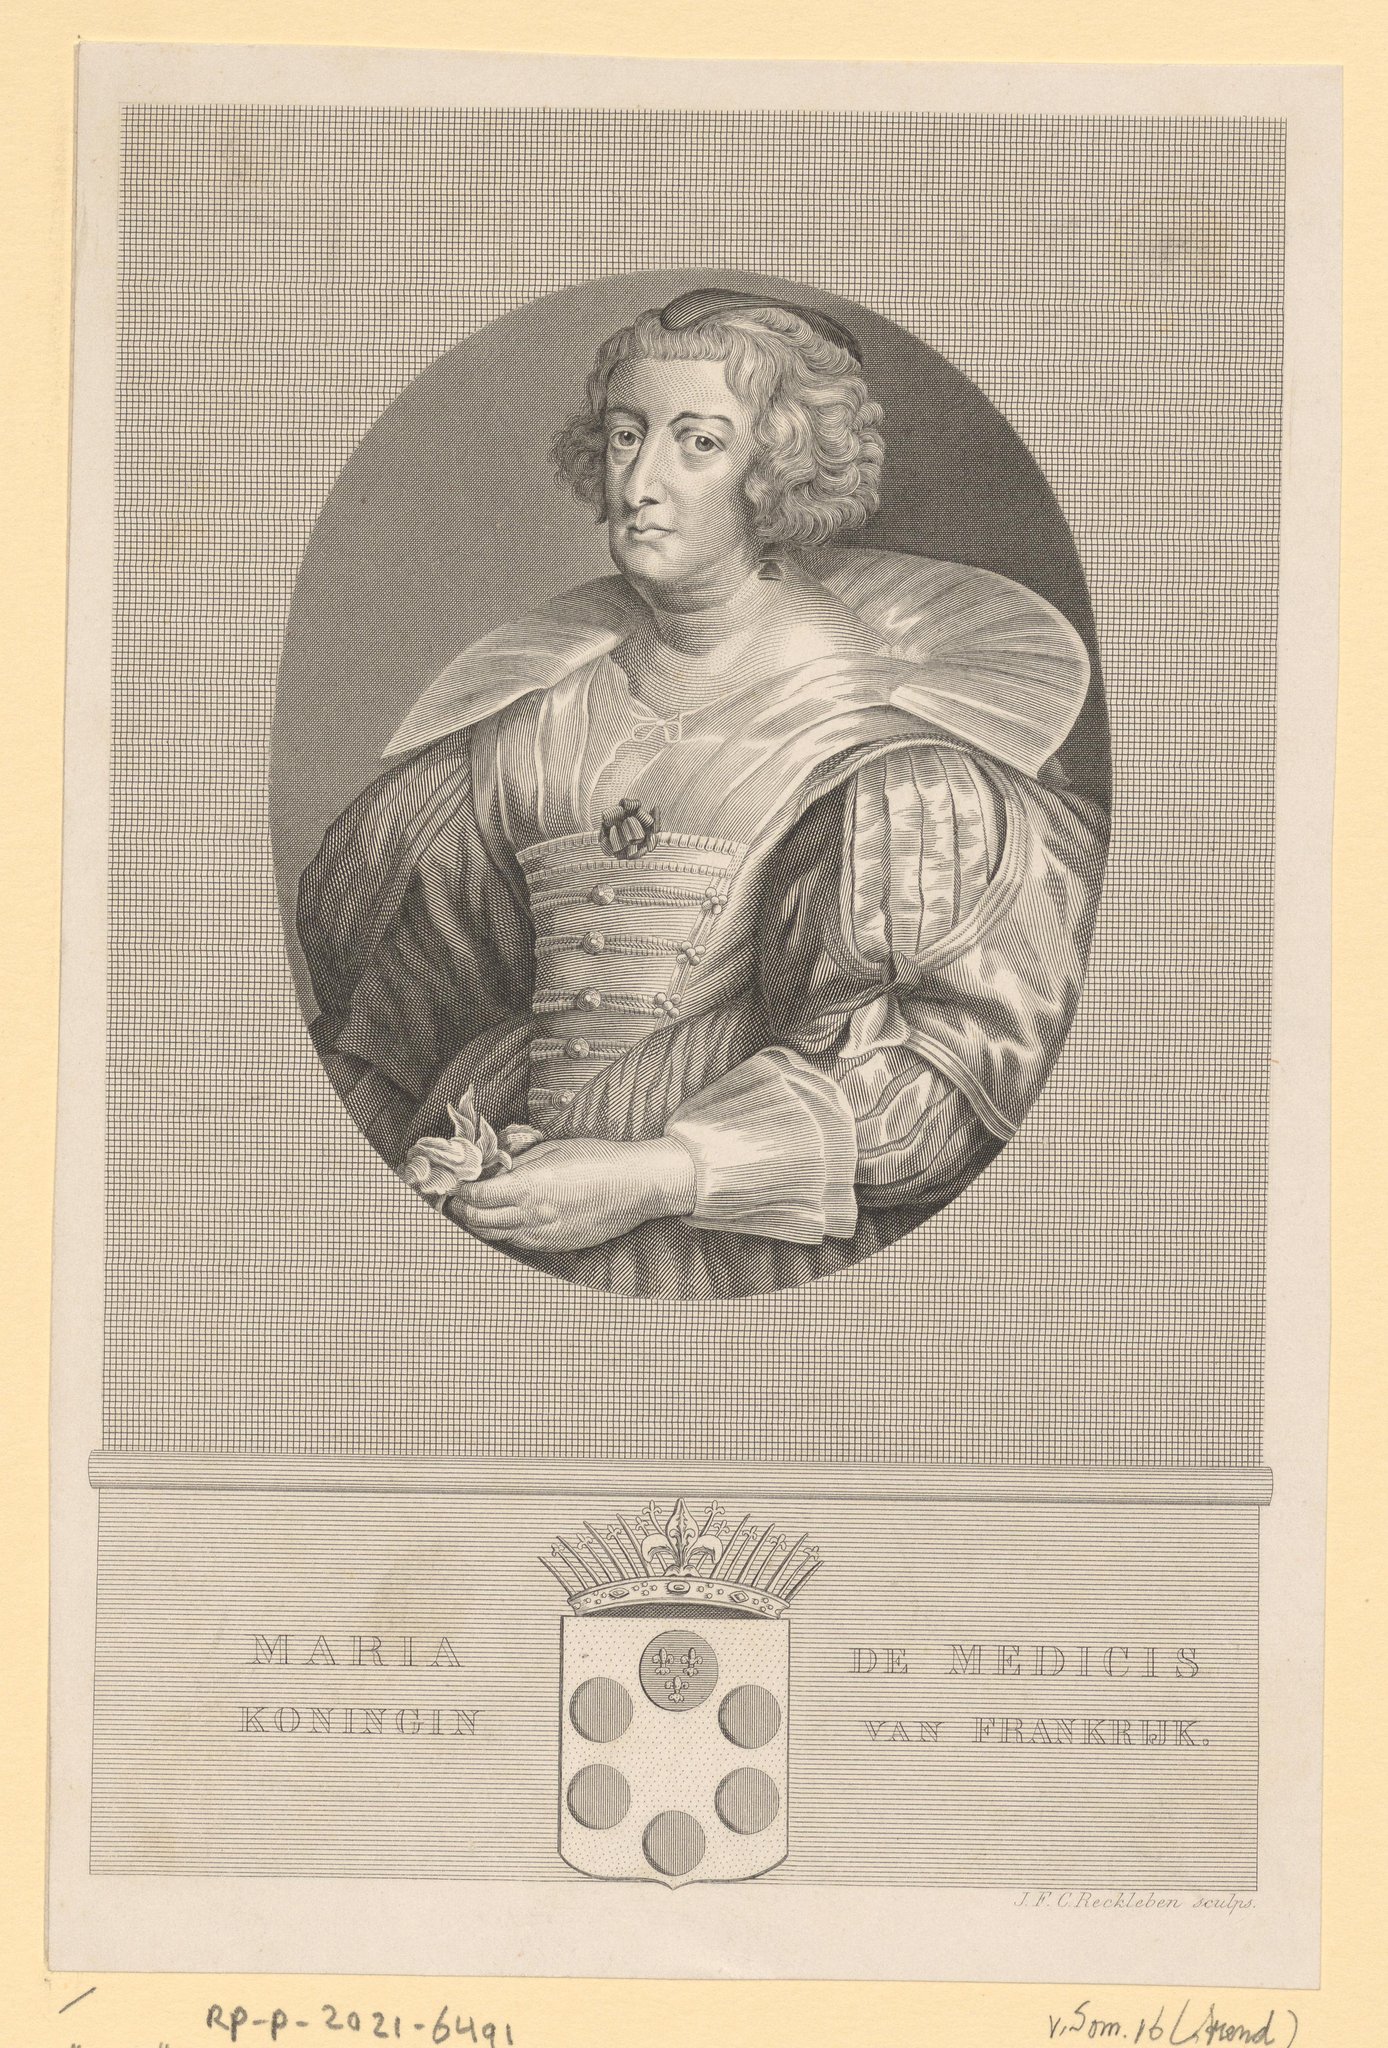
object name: book illustration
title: Portret van Maria de' Medici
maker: jan frederik christiaan reckleben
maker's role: print maker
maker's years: 1819-1879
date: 1868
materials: paper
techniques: engraving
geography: amsterdam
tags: cologne, maria de' medici, historical persons - bb - woman, queen, armorial bearing, heraldry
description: Prent waarschijnlijk uit: Arend, Johannes Pieter. Algemeene geschiedenis des vaderlands van de vroegste tijden tot op heden. 5 dln. Amsterdam: C.L. Schleijer & zoon, 1868, dl. 3-5.